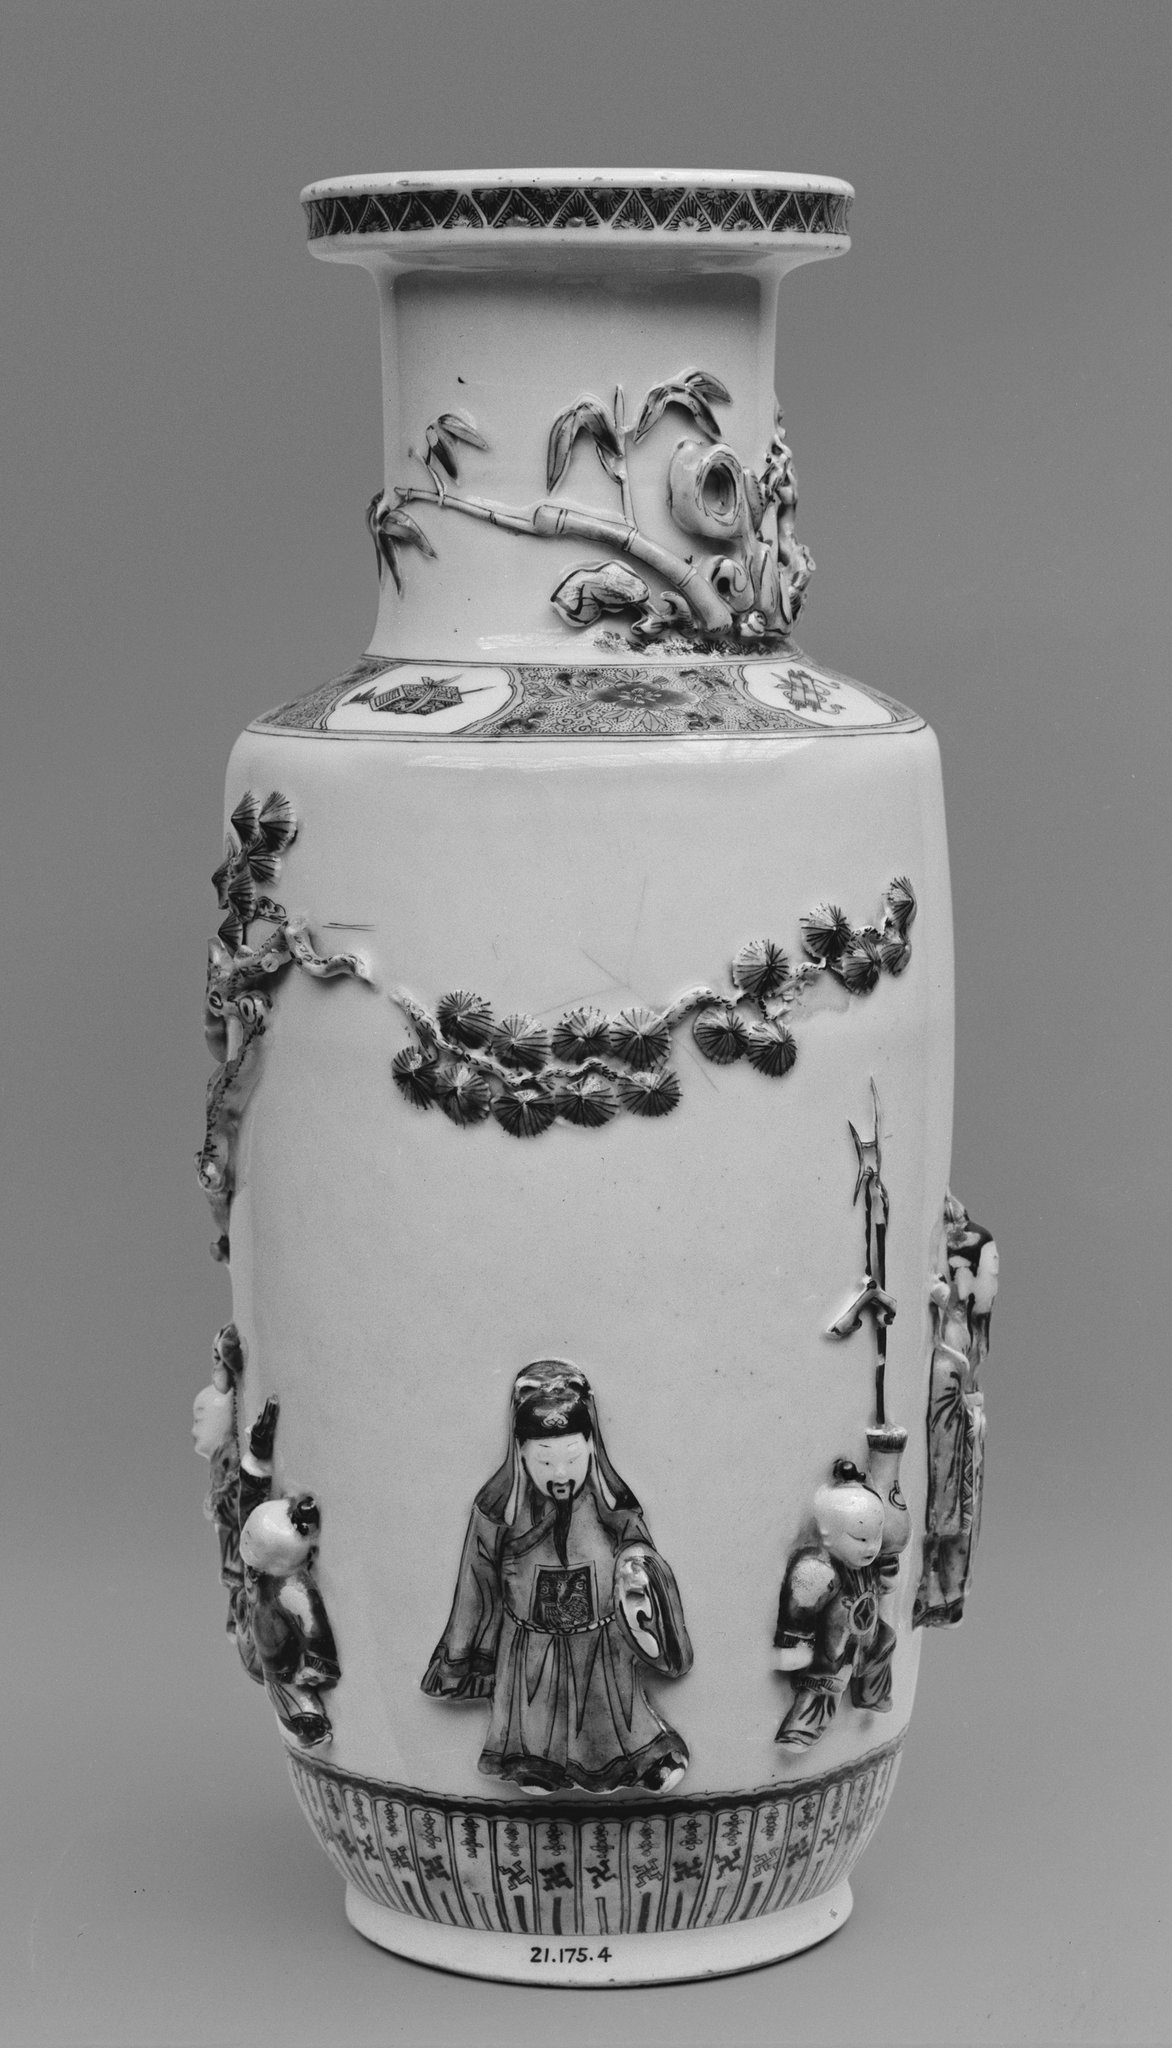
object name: vase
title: Vase with immortals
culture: chinese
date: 1701-1733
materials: enamel, porcelain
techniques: overglaze, painting, polychrome, relief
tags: boys,men